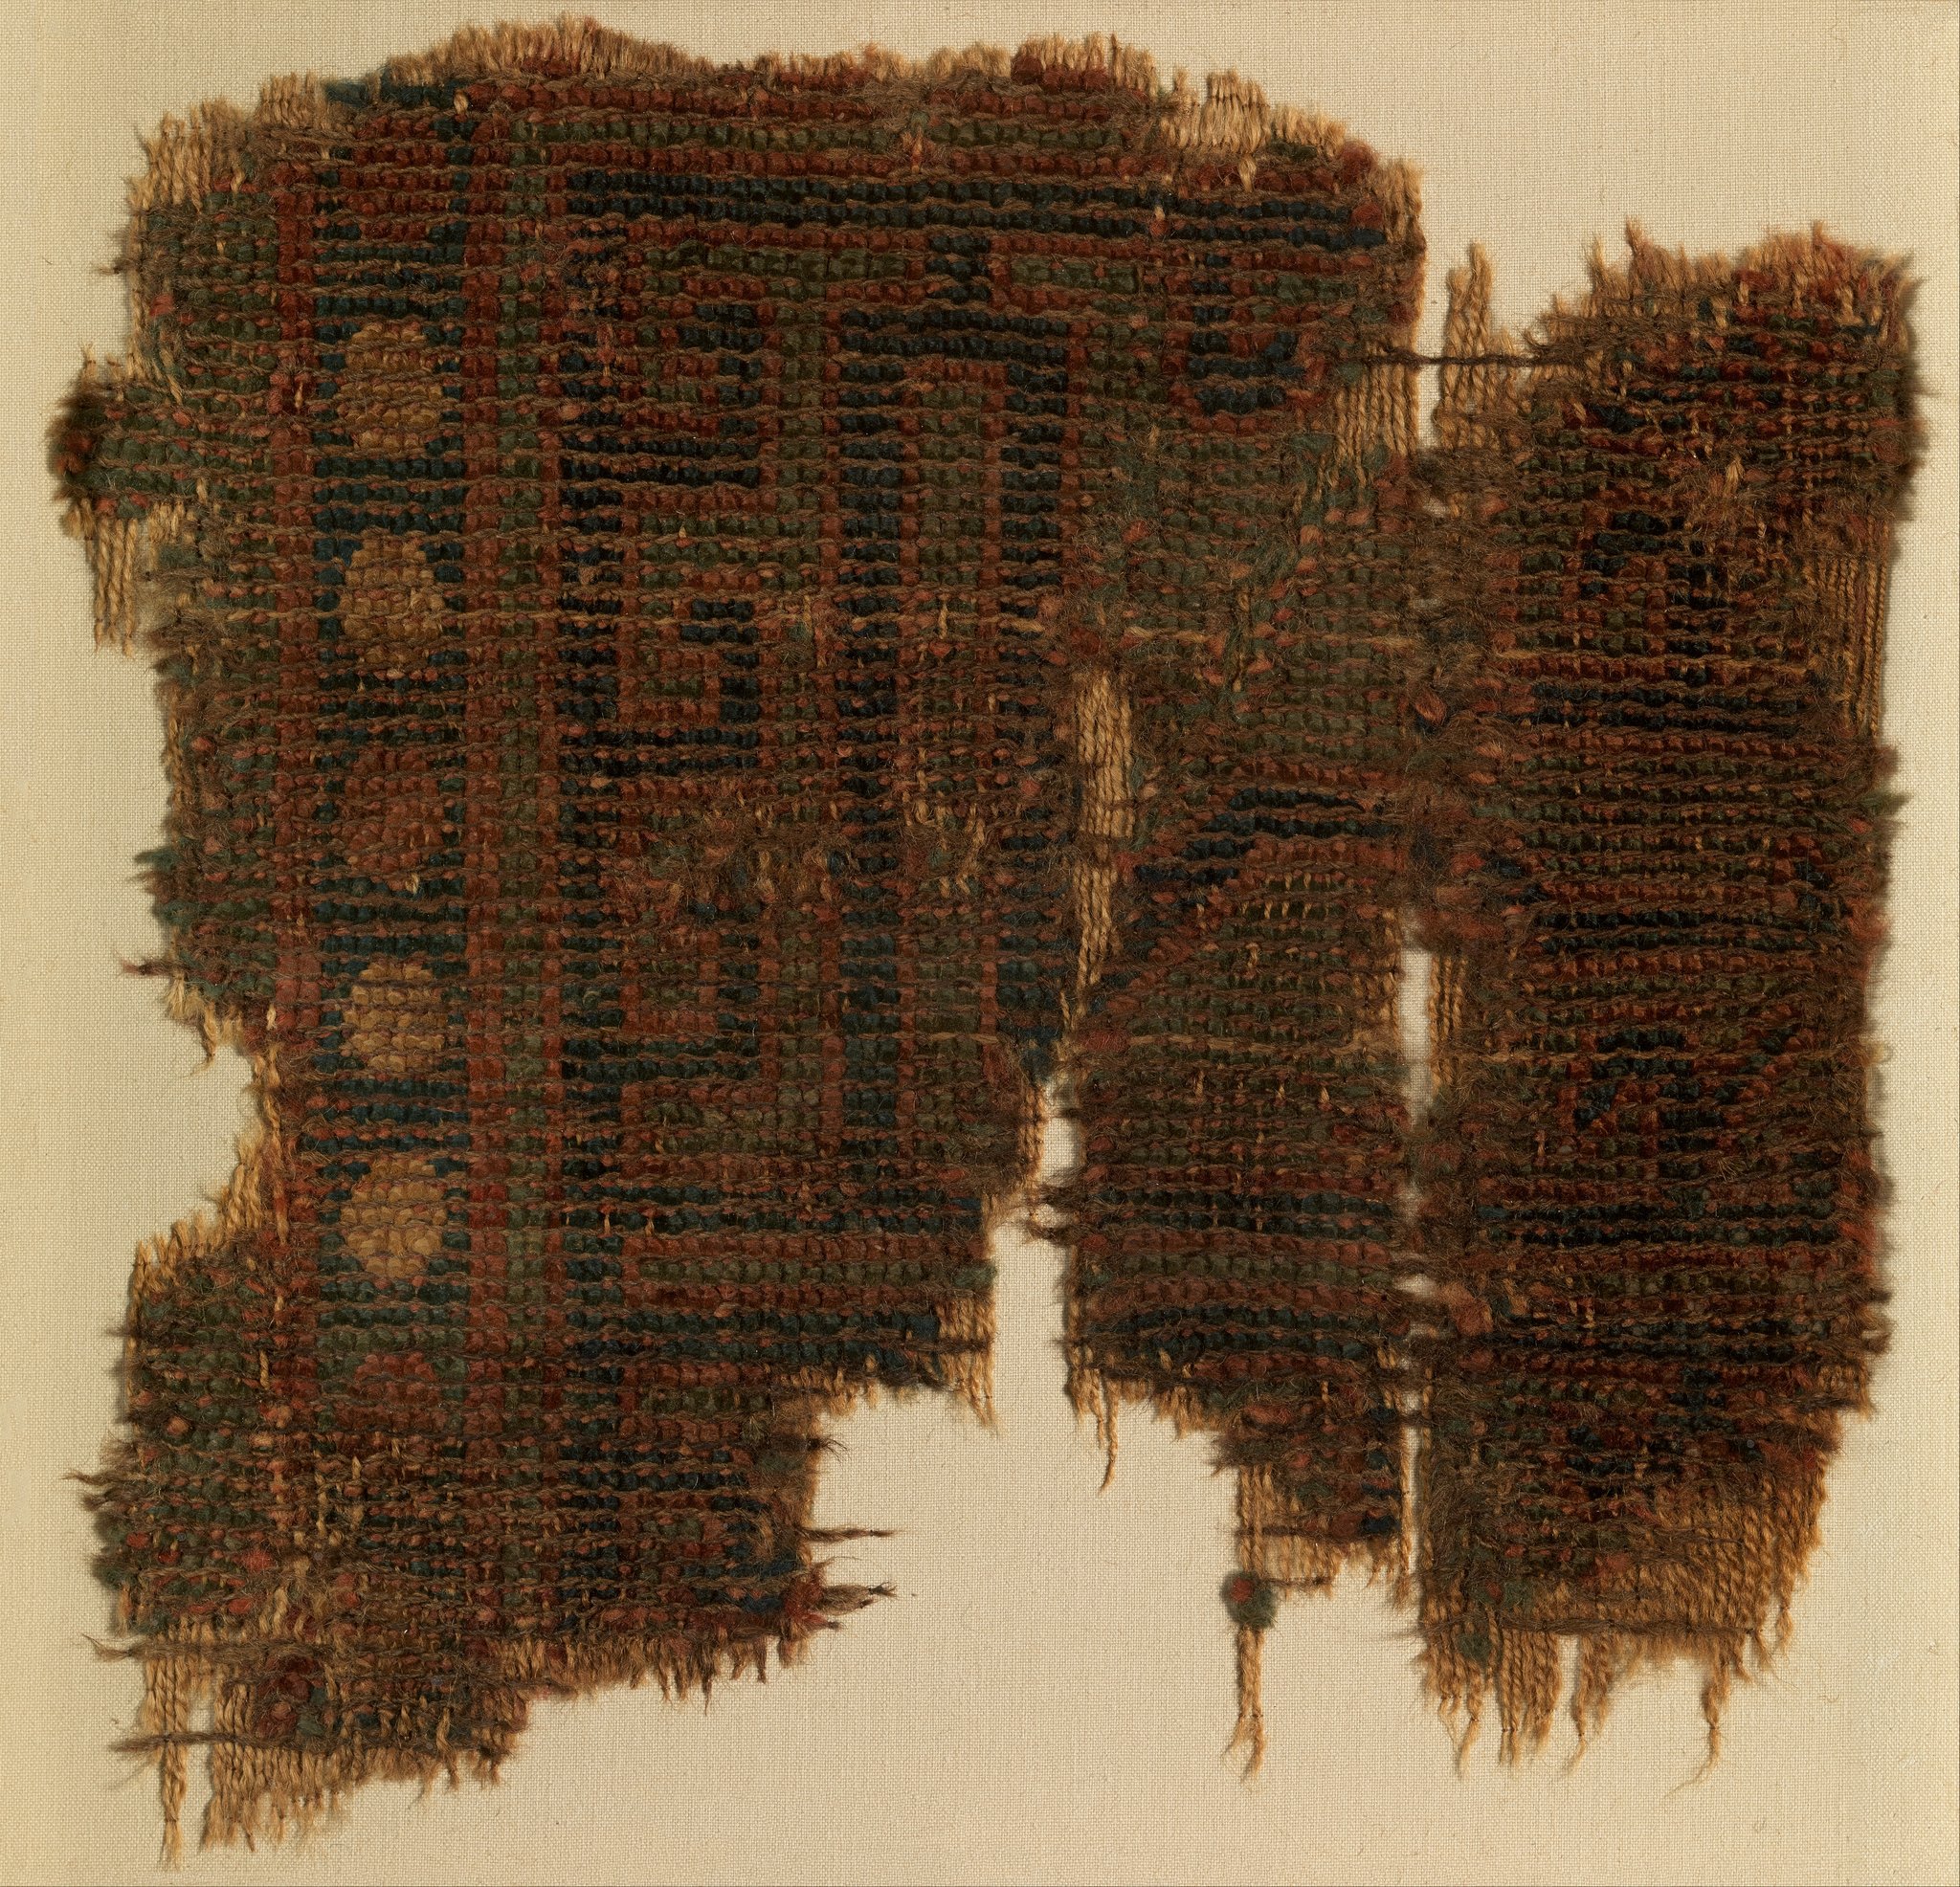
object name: carpet fragment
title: Fragment of a Carpet with Geometric Design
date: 1301-1400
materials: wool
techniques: pile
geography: turkey